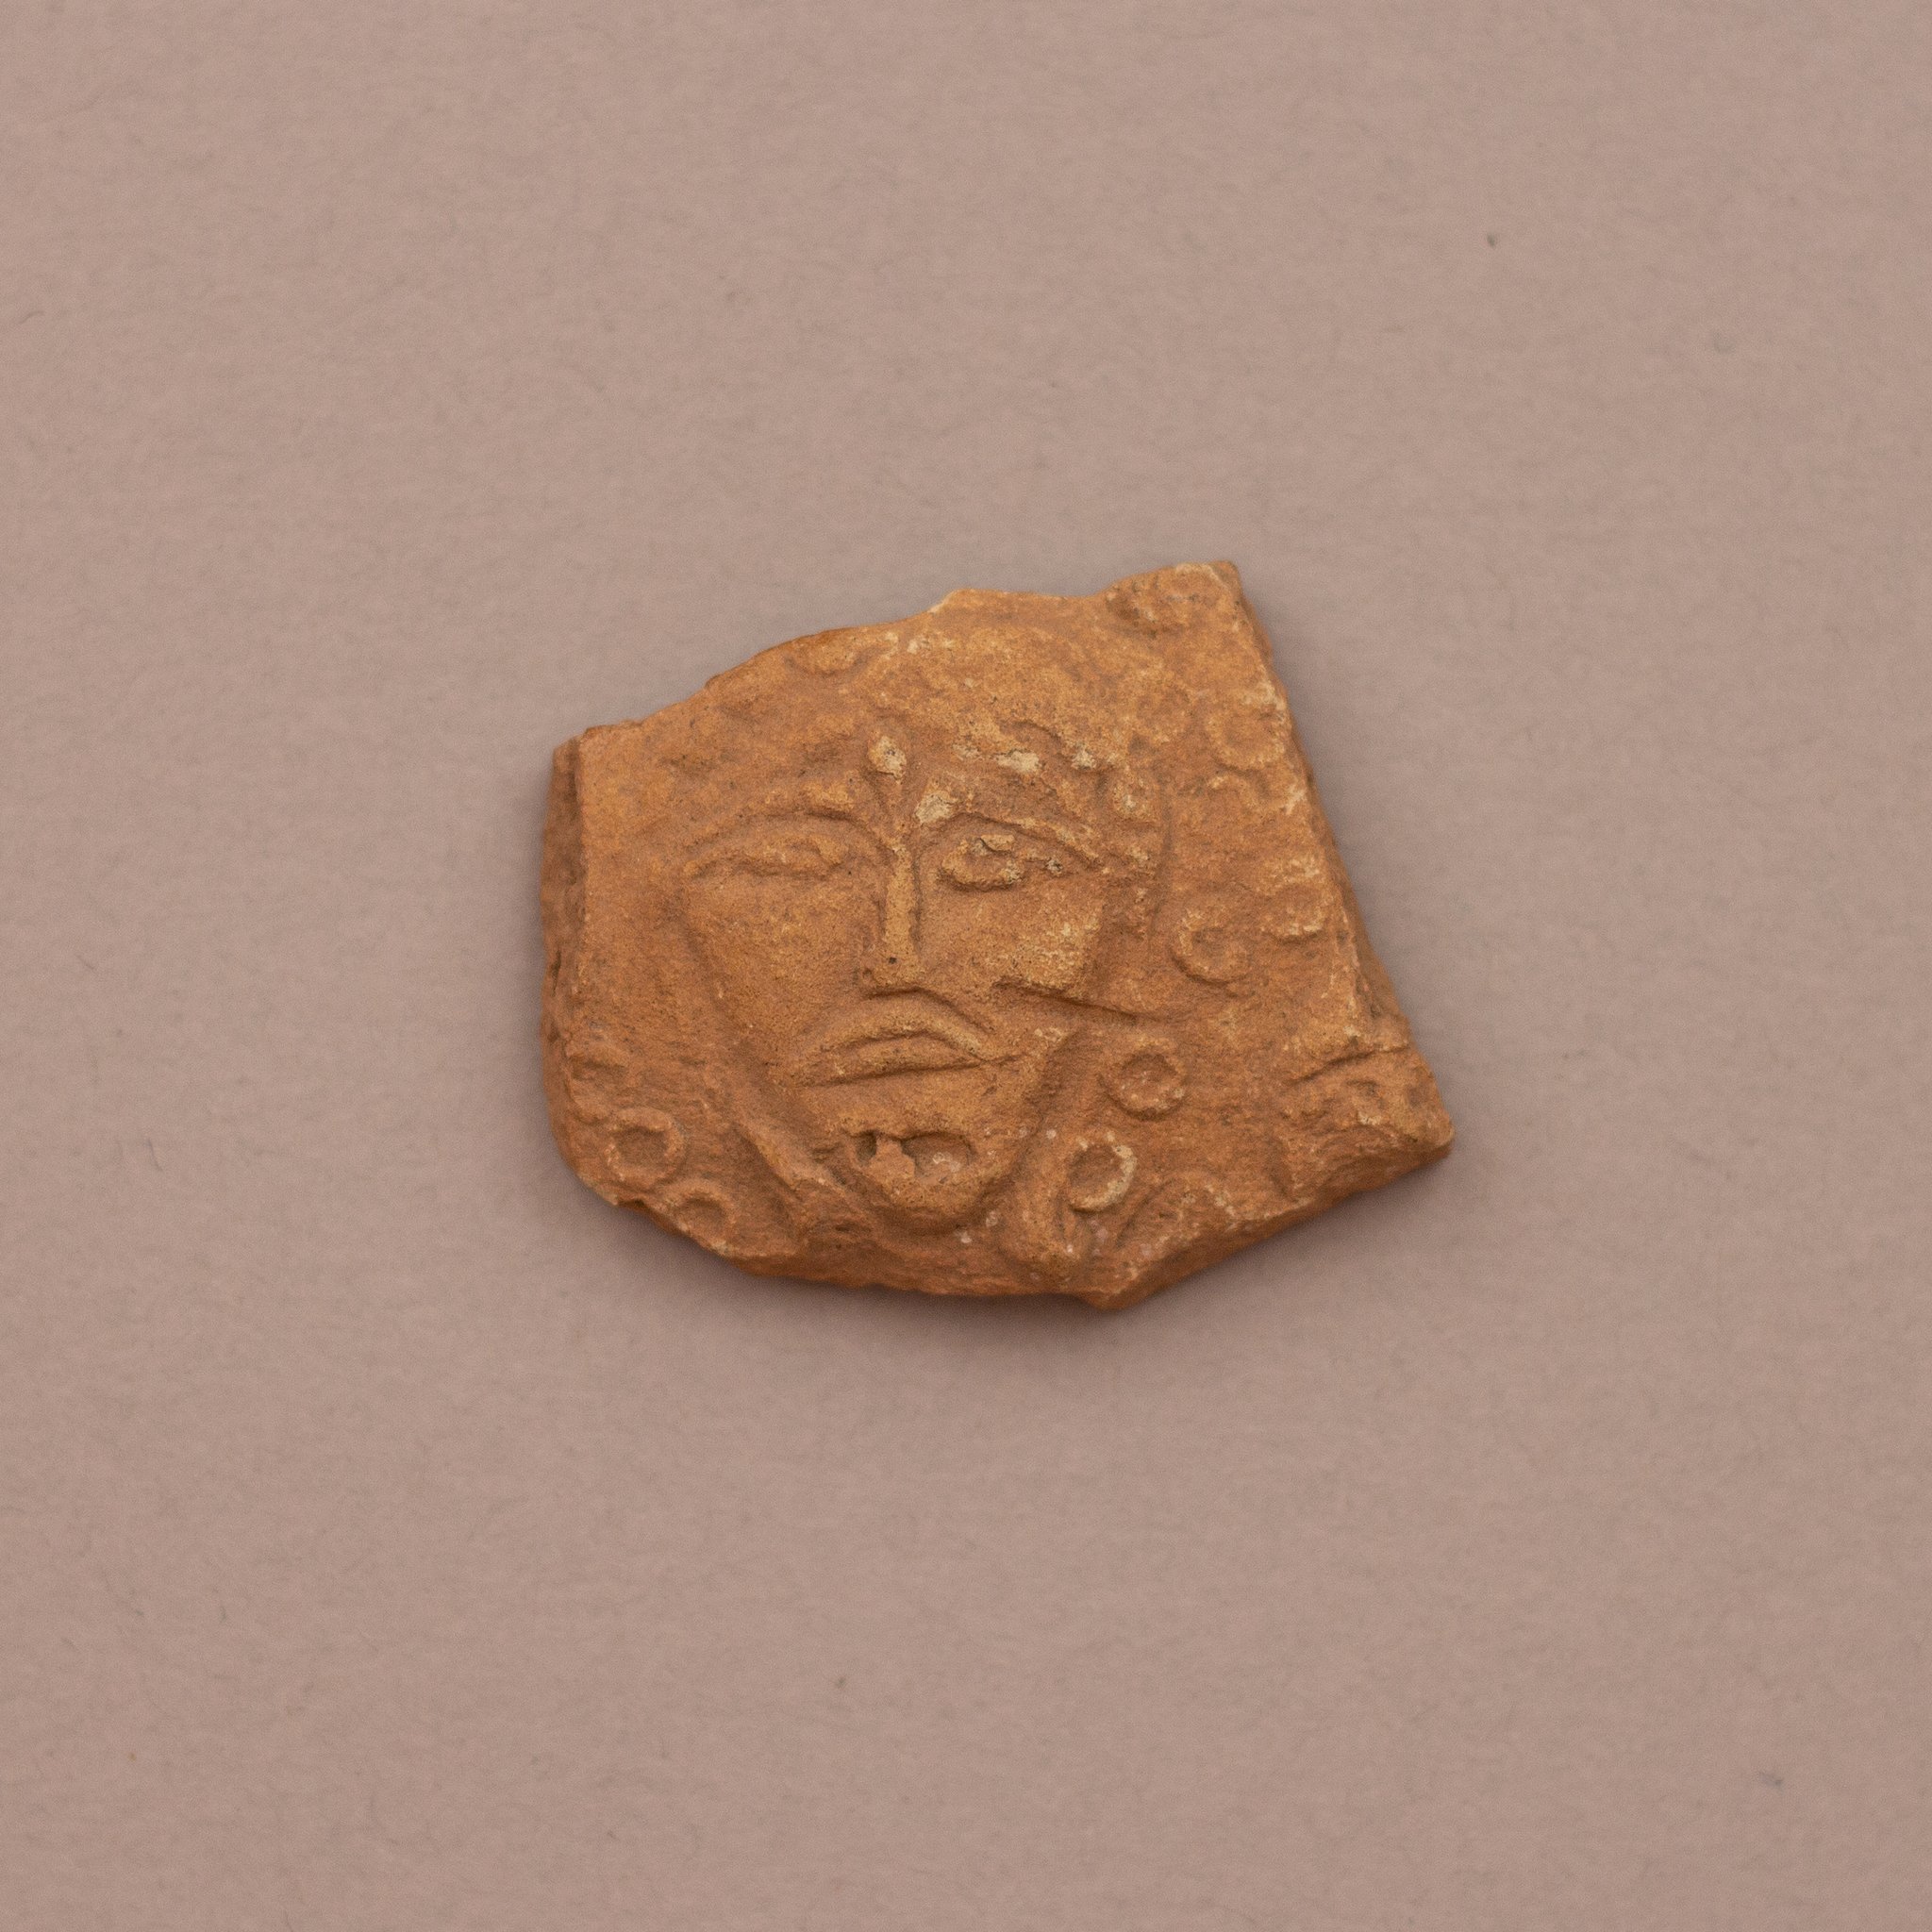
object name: fragment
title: Ceramic Fragment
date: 801-1000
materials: earthenware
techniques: molding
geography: iran